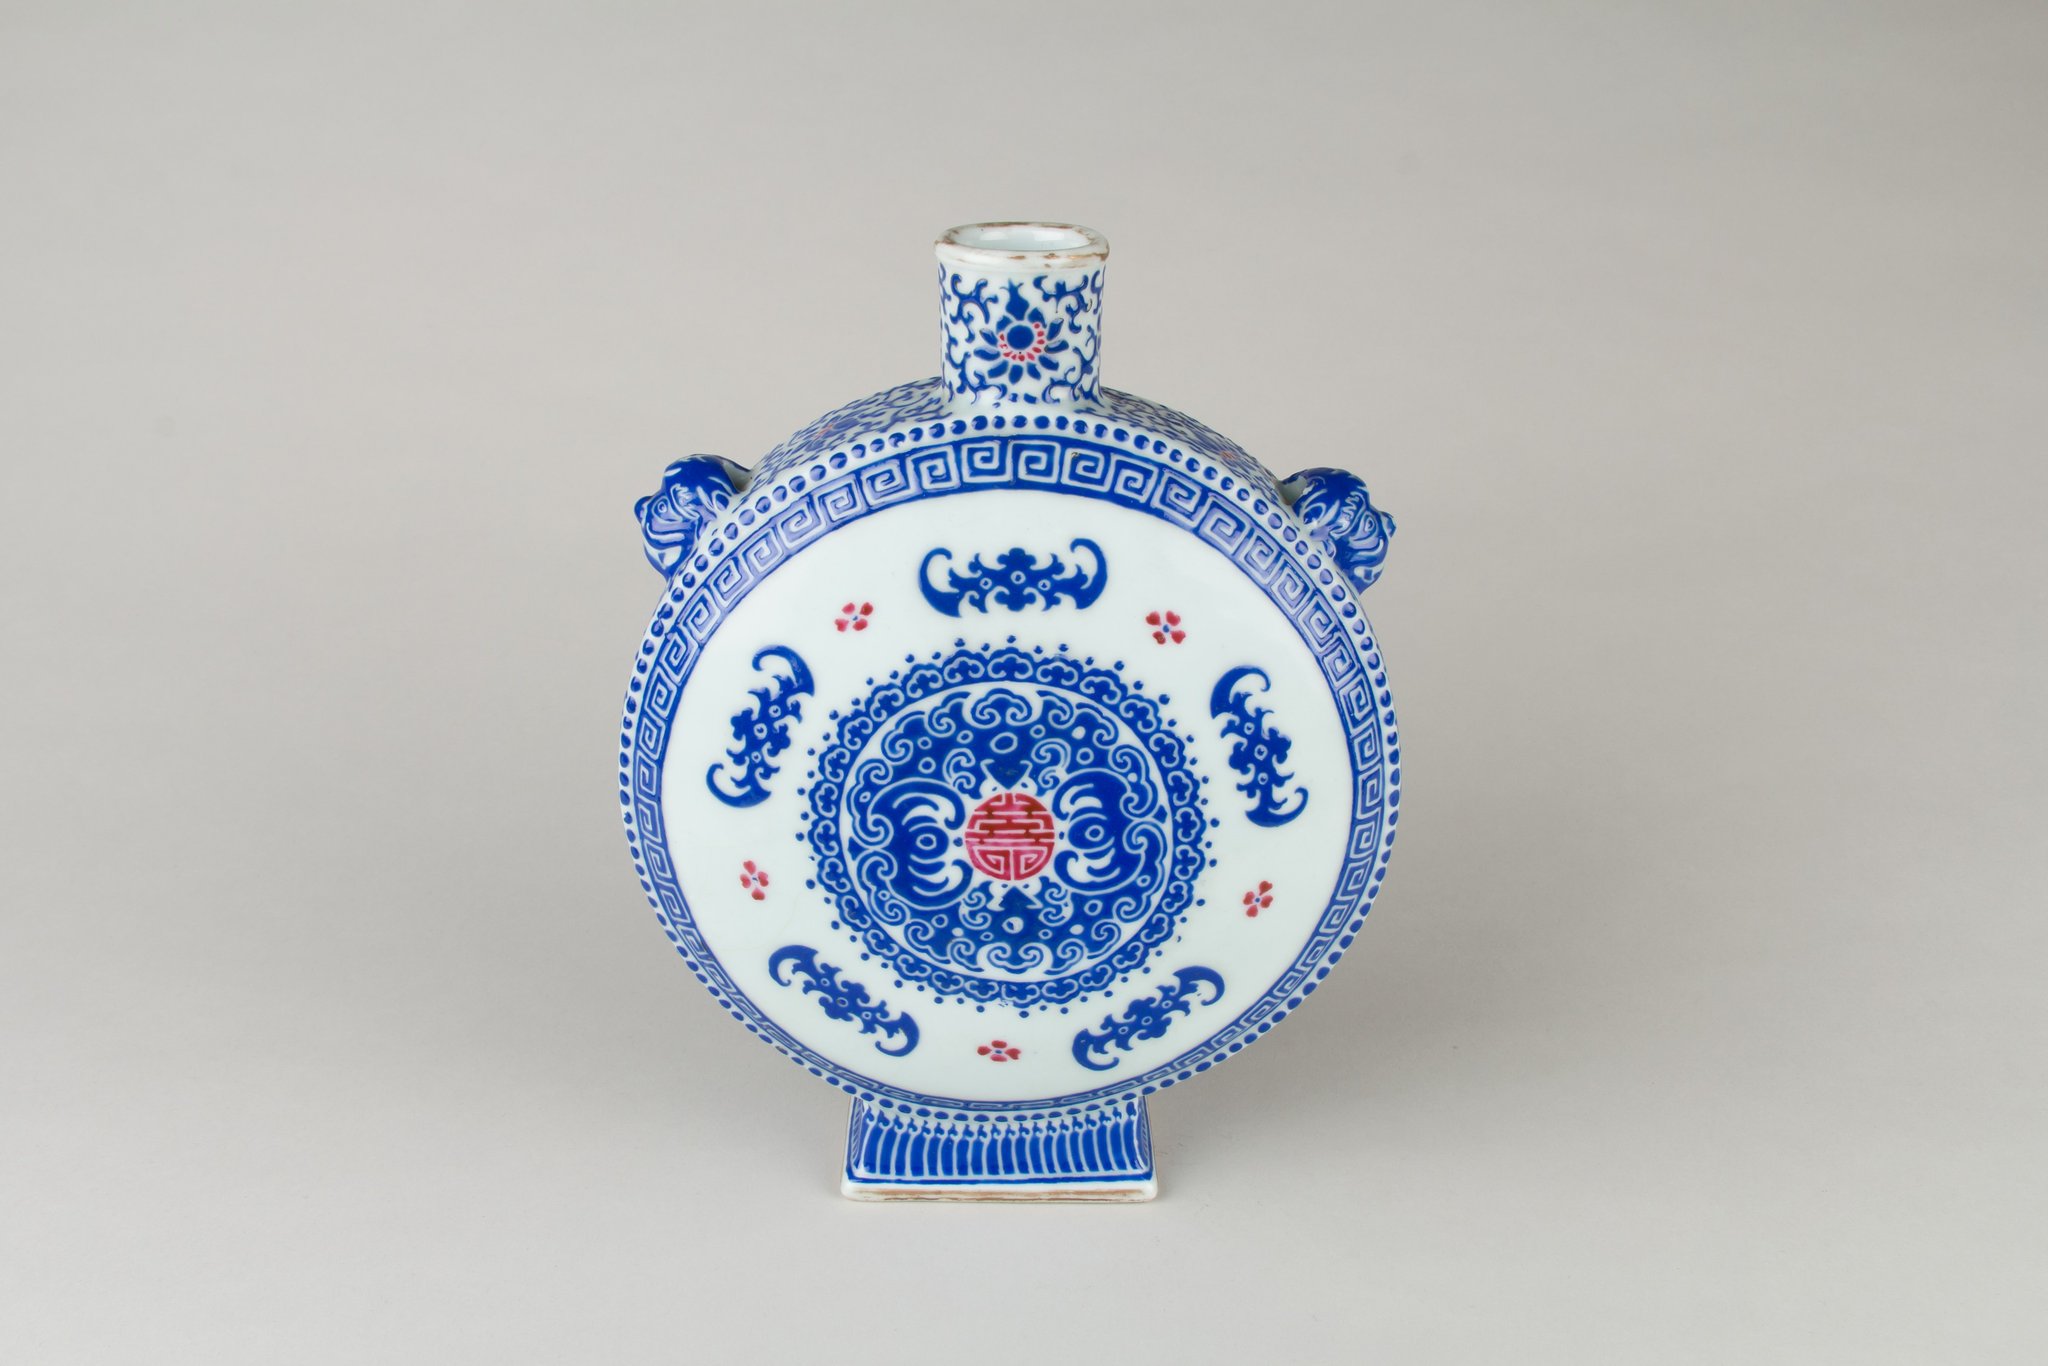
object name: flask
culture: chinese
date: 1644-1911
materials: enamel, porcelain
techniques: overglaze, painting